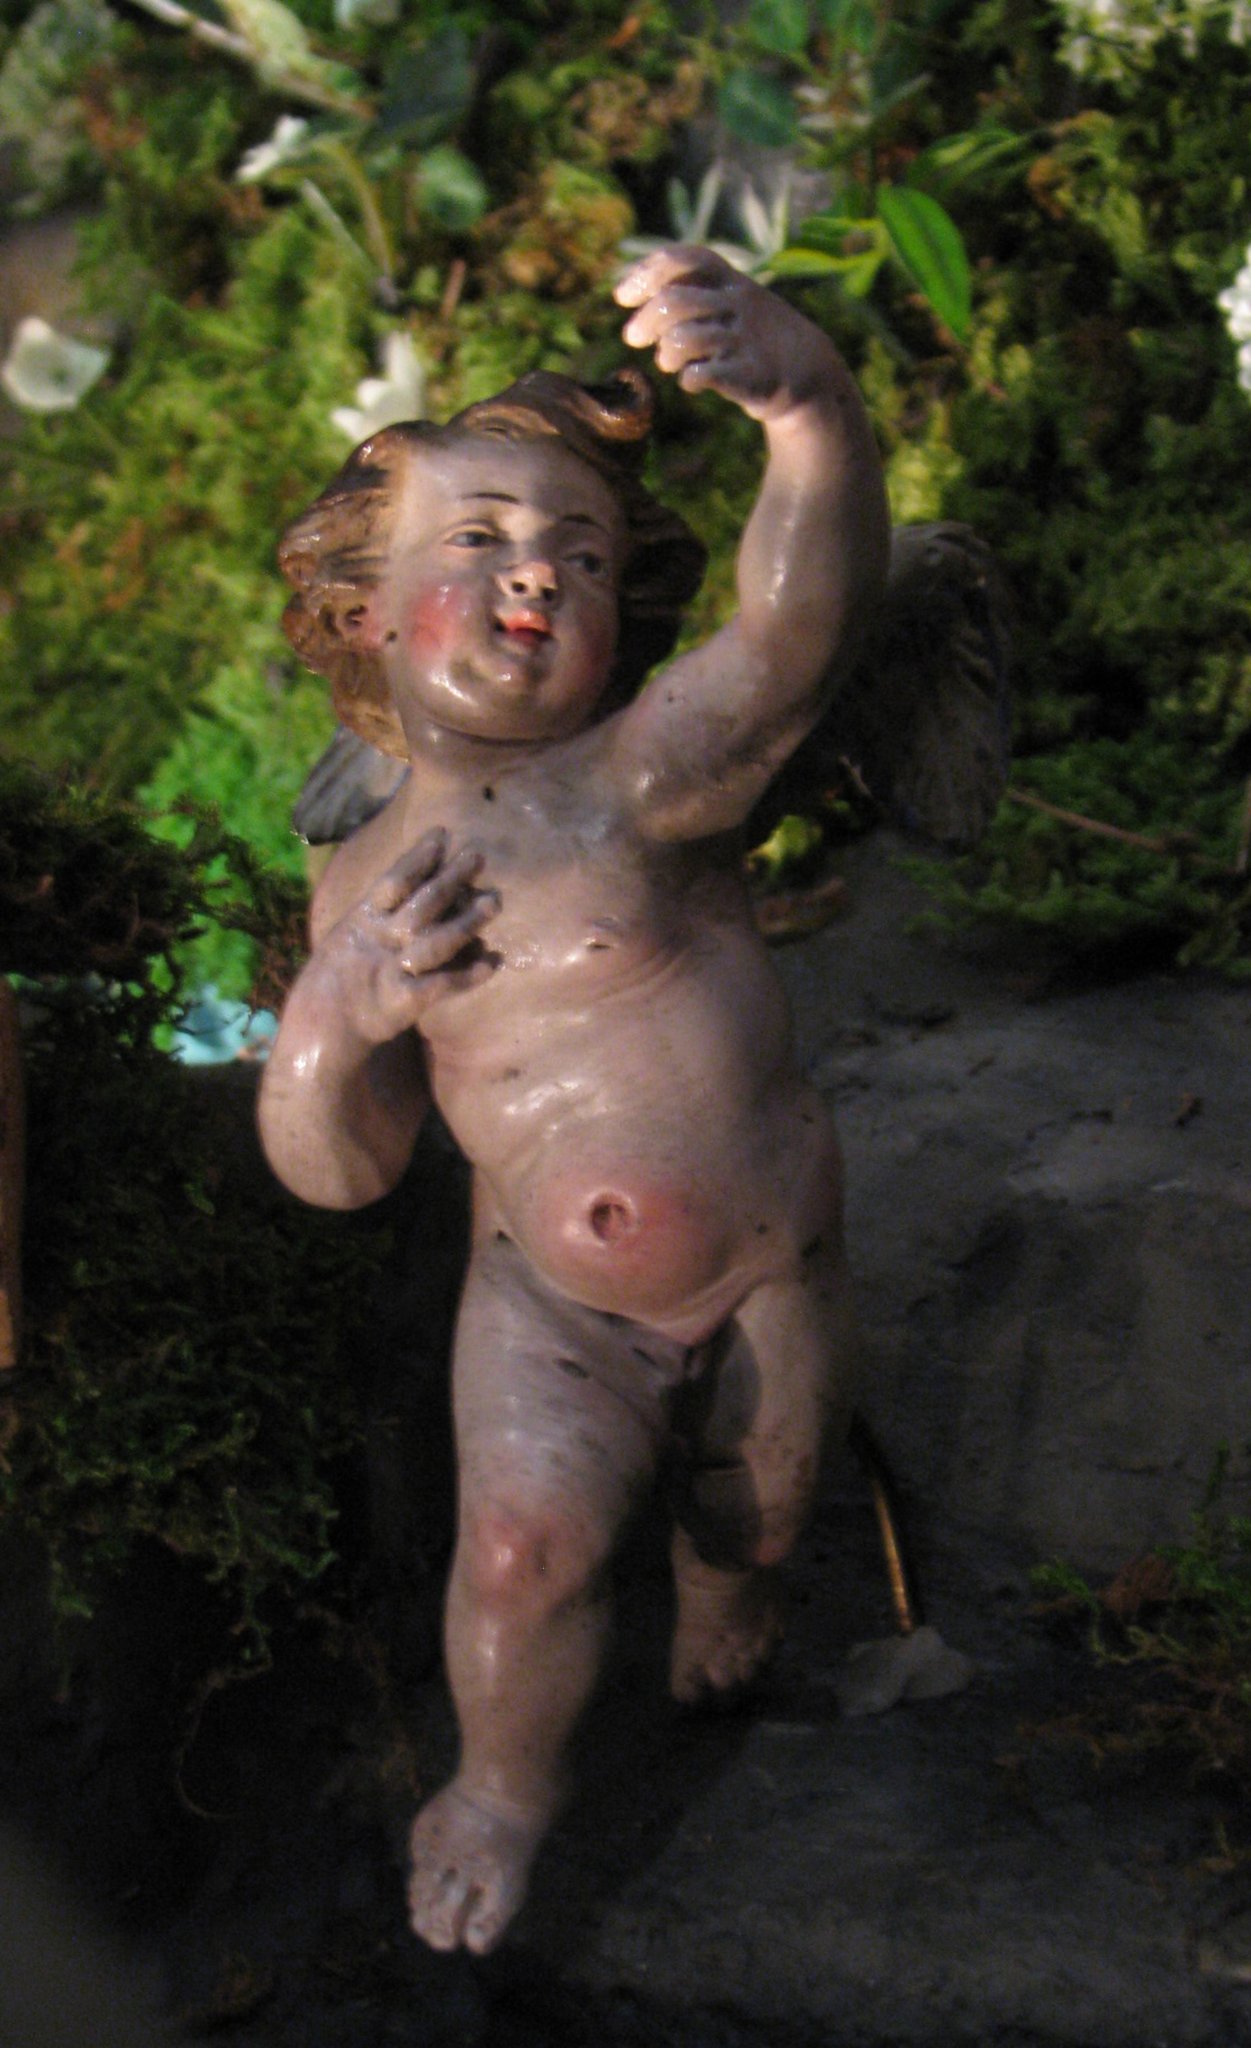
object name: crèche figure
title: Cherub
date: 1751-1800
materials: terracotta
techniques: polychrome